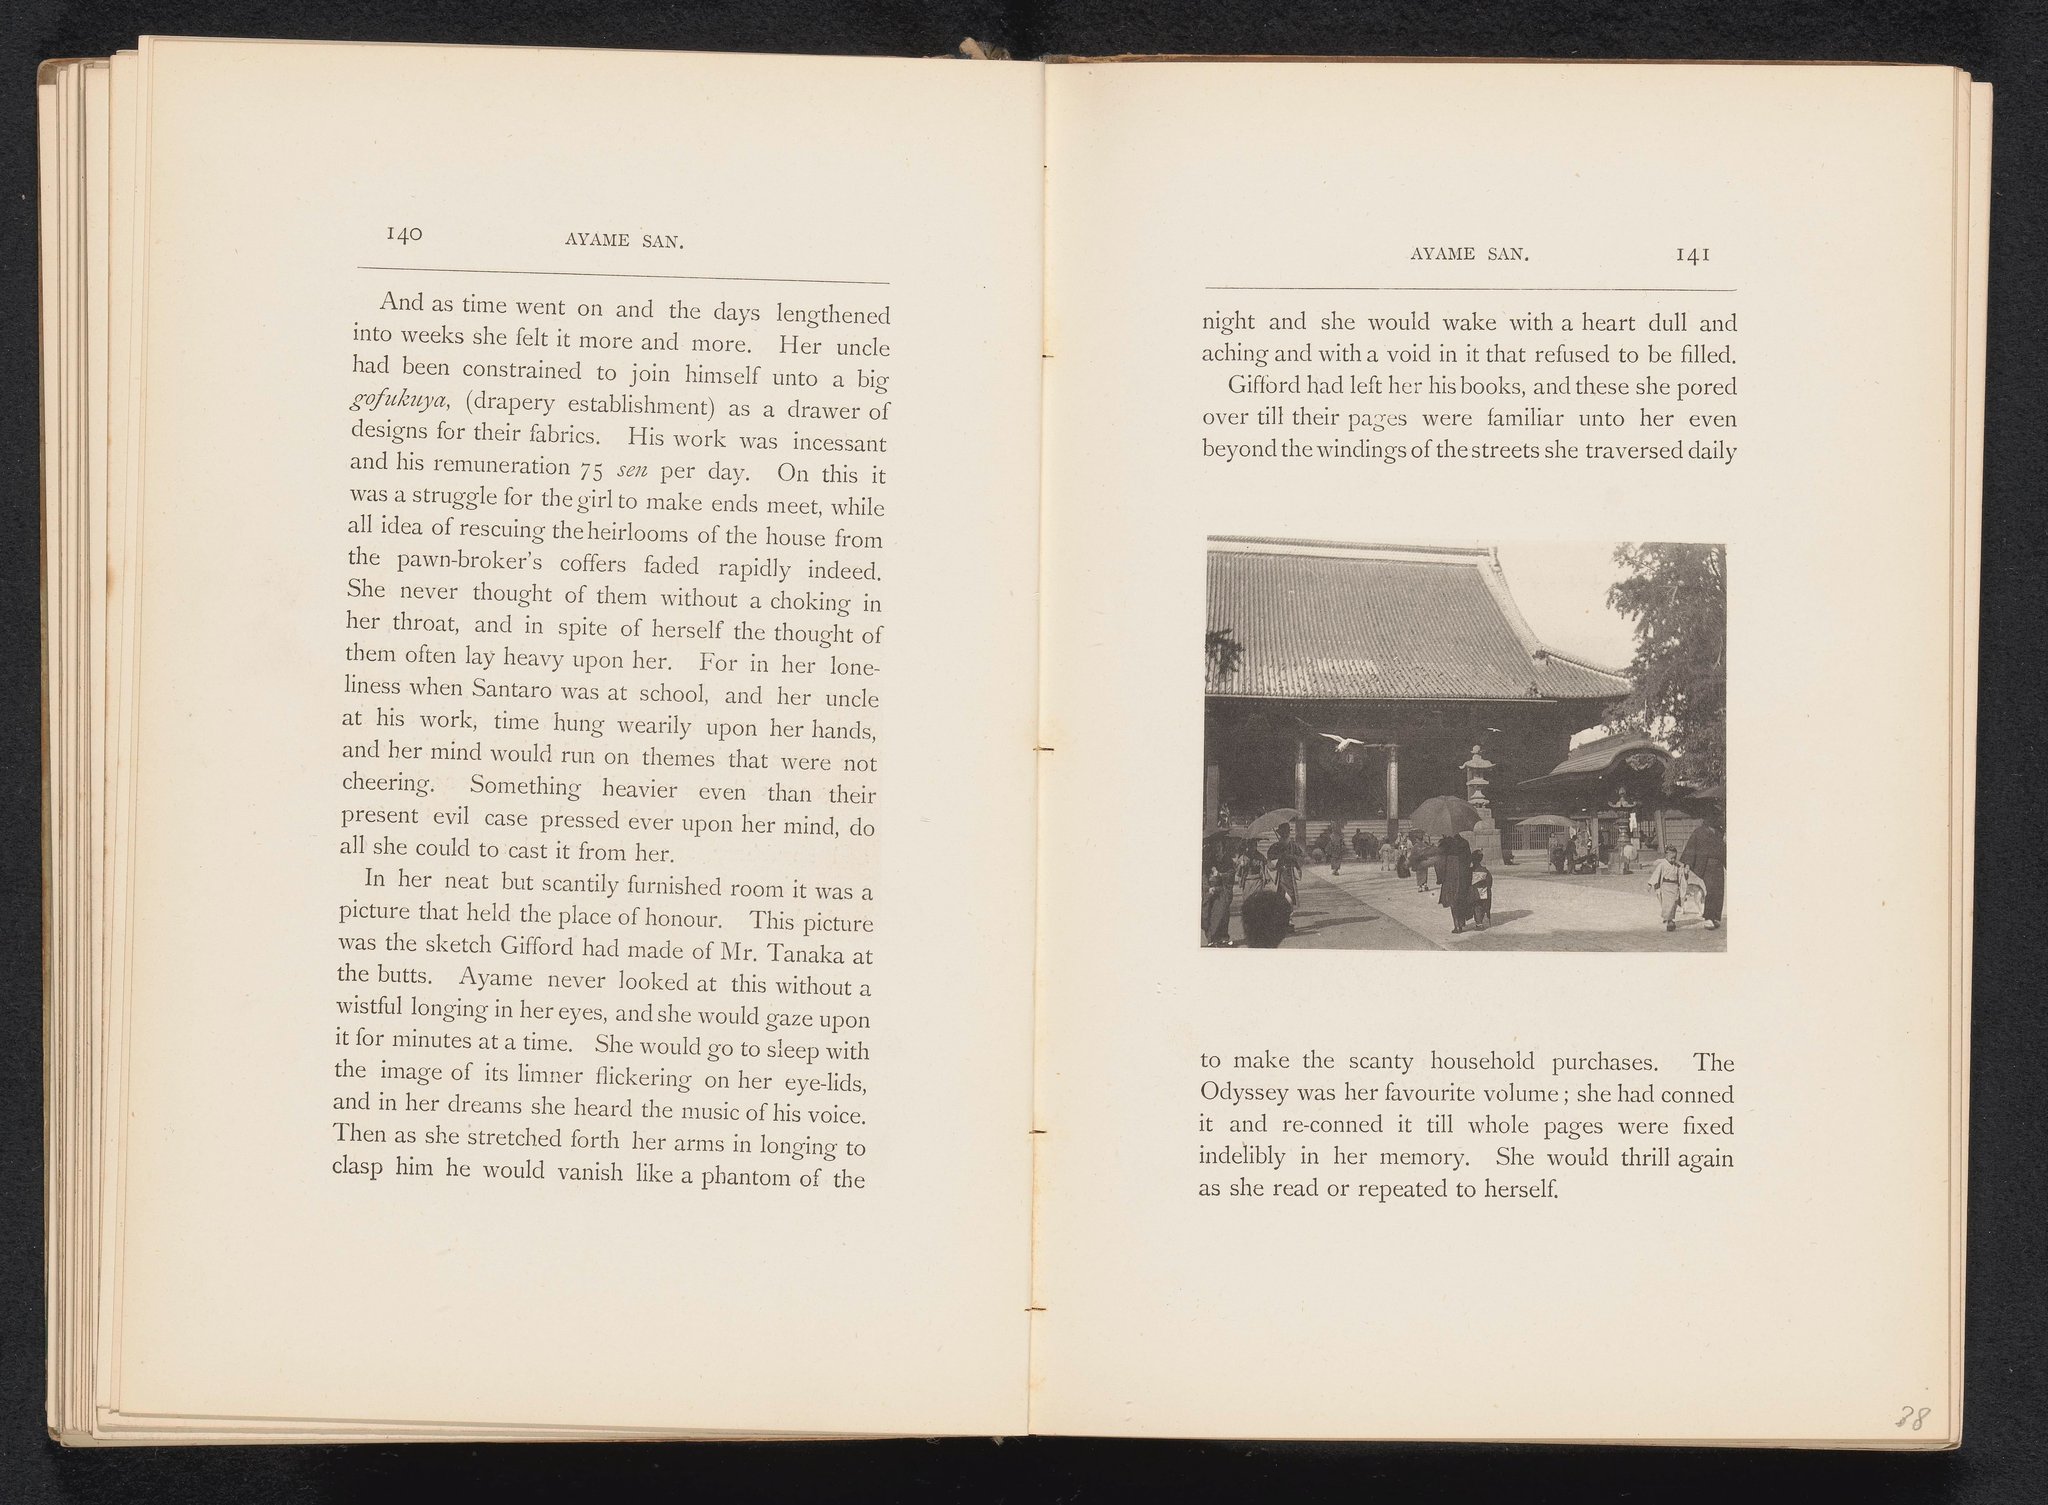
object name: photomechanical print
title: Plein voor (vermoedelijk) een tempel te Japan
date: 1882-1892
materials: paper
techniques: photograph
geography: japan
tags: square, place, circus, etc., temple, shrine ~ non-christian religions, façade (of house or building)